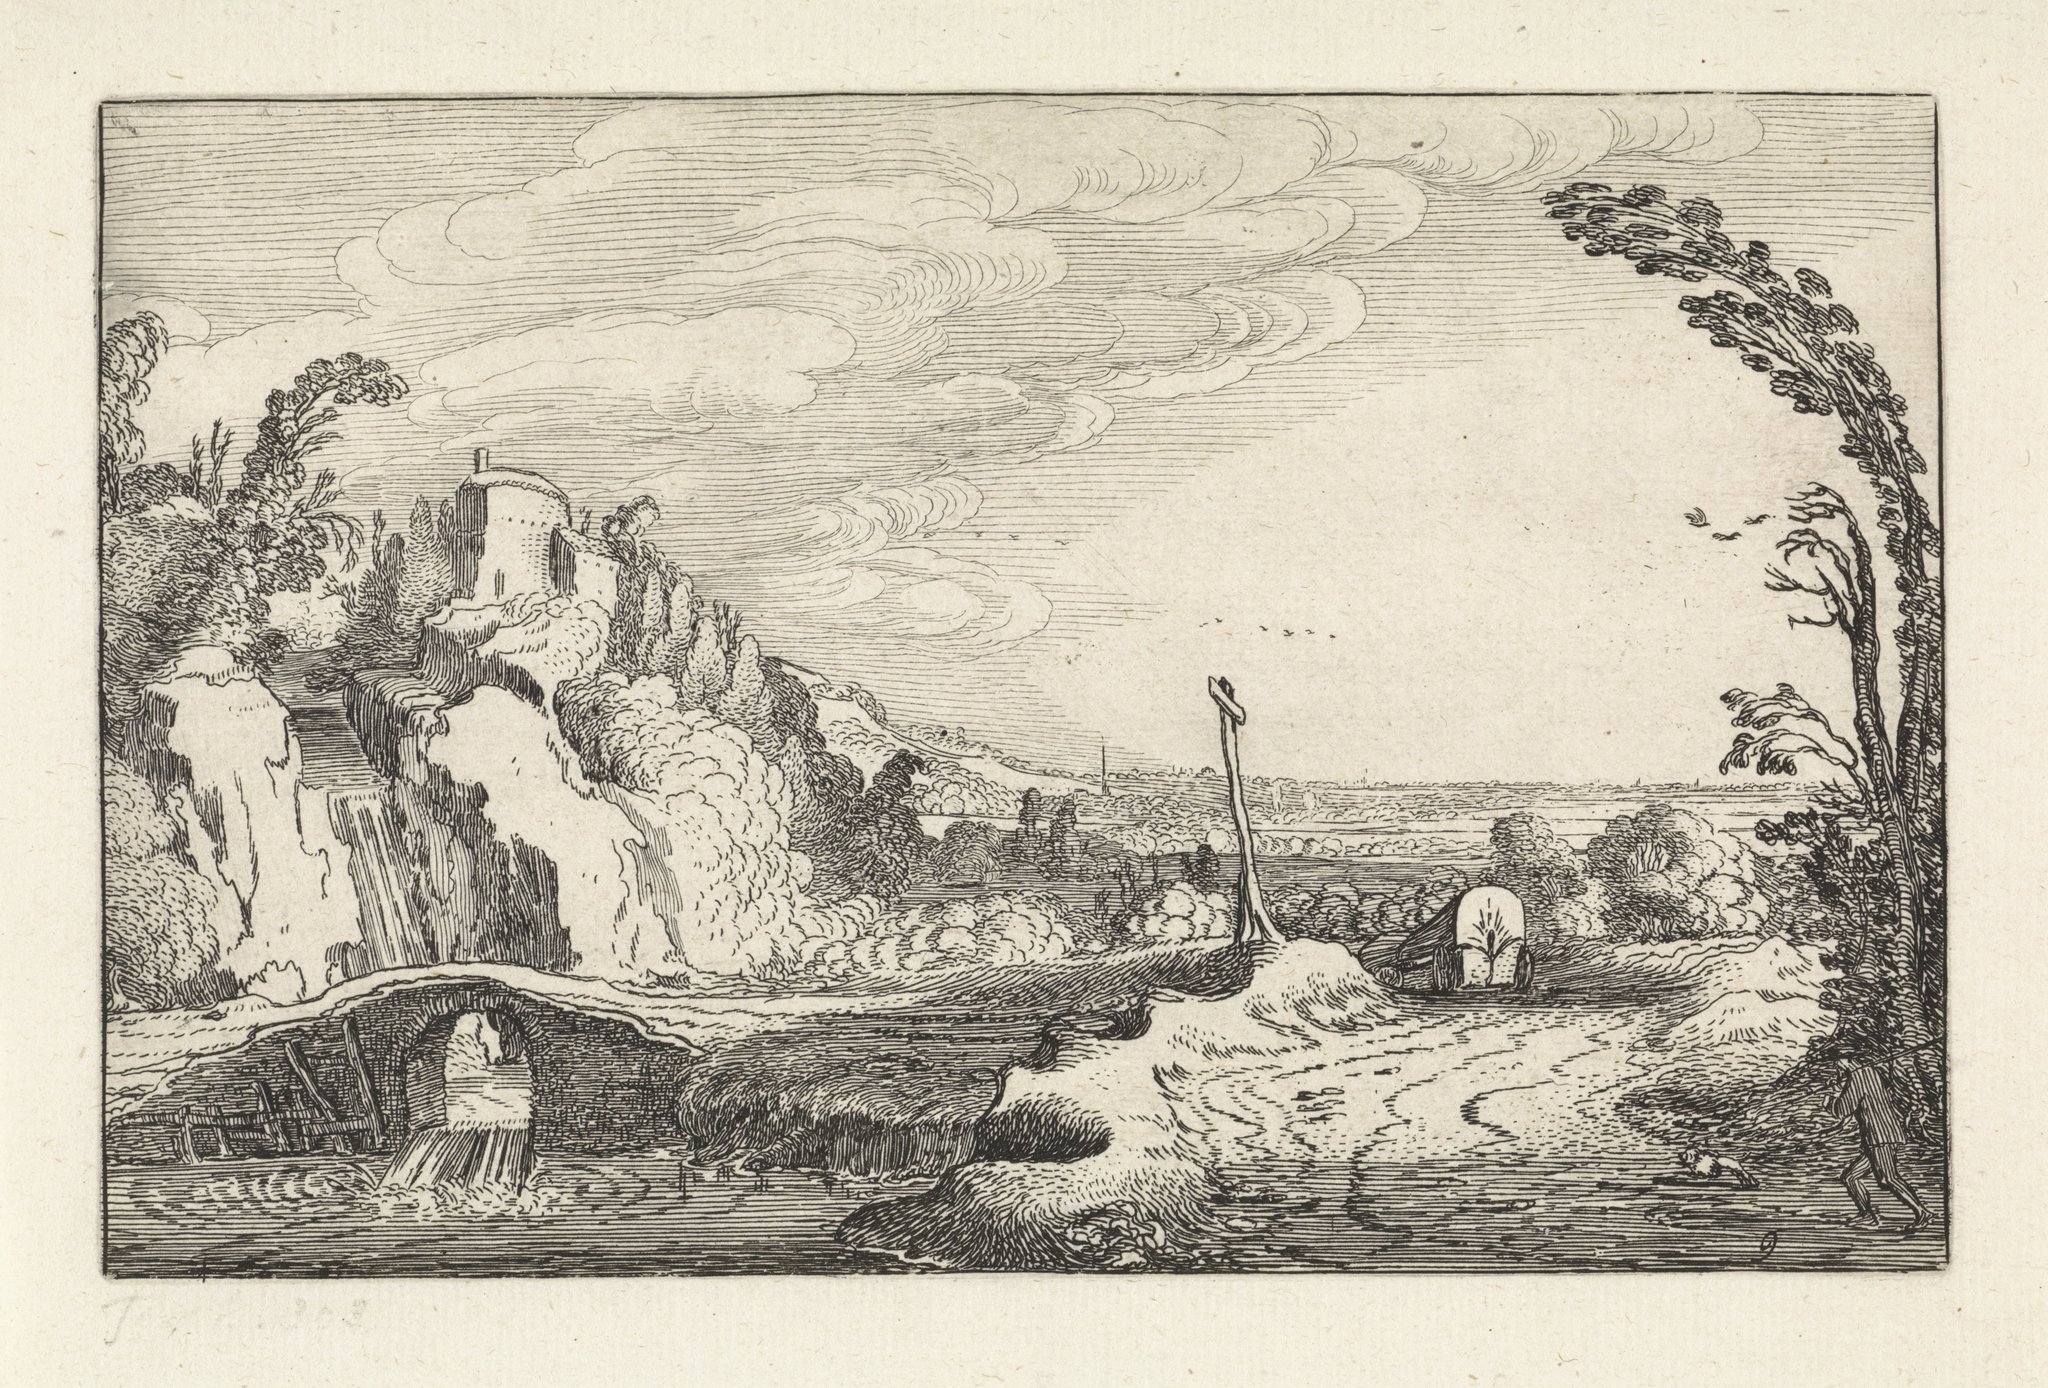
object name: print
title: Huifkar op een pad in een bergachtig rivierlandschap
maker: jan van de velde (ii)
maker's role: draughtsman, painter, print maker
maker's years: 1593-1641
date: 1616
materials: paper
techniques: etching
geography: northern netherlands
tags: river, landscape with bridge, viaduct or aqueduct, (high) hill, covered wagon, hooded wagon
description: Een man met een hond en een huifkar op een landweg langs een rivier met een stenen brug. Links een gebouw op een berg. Negende prent van een serie van in totaal 52 prenten met landschappen, verdeeld over twee delen van elk 26 prenten.